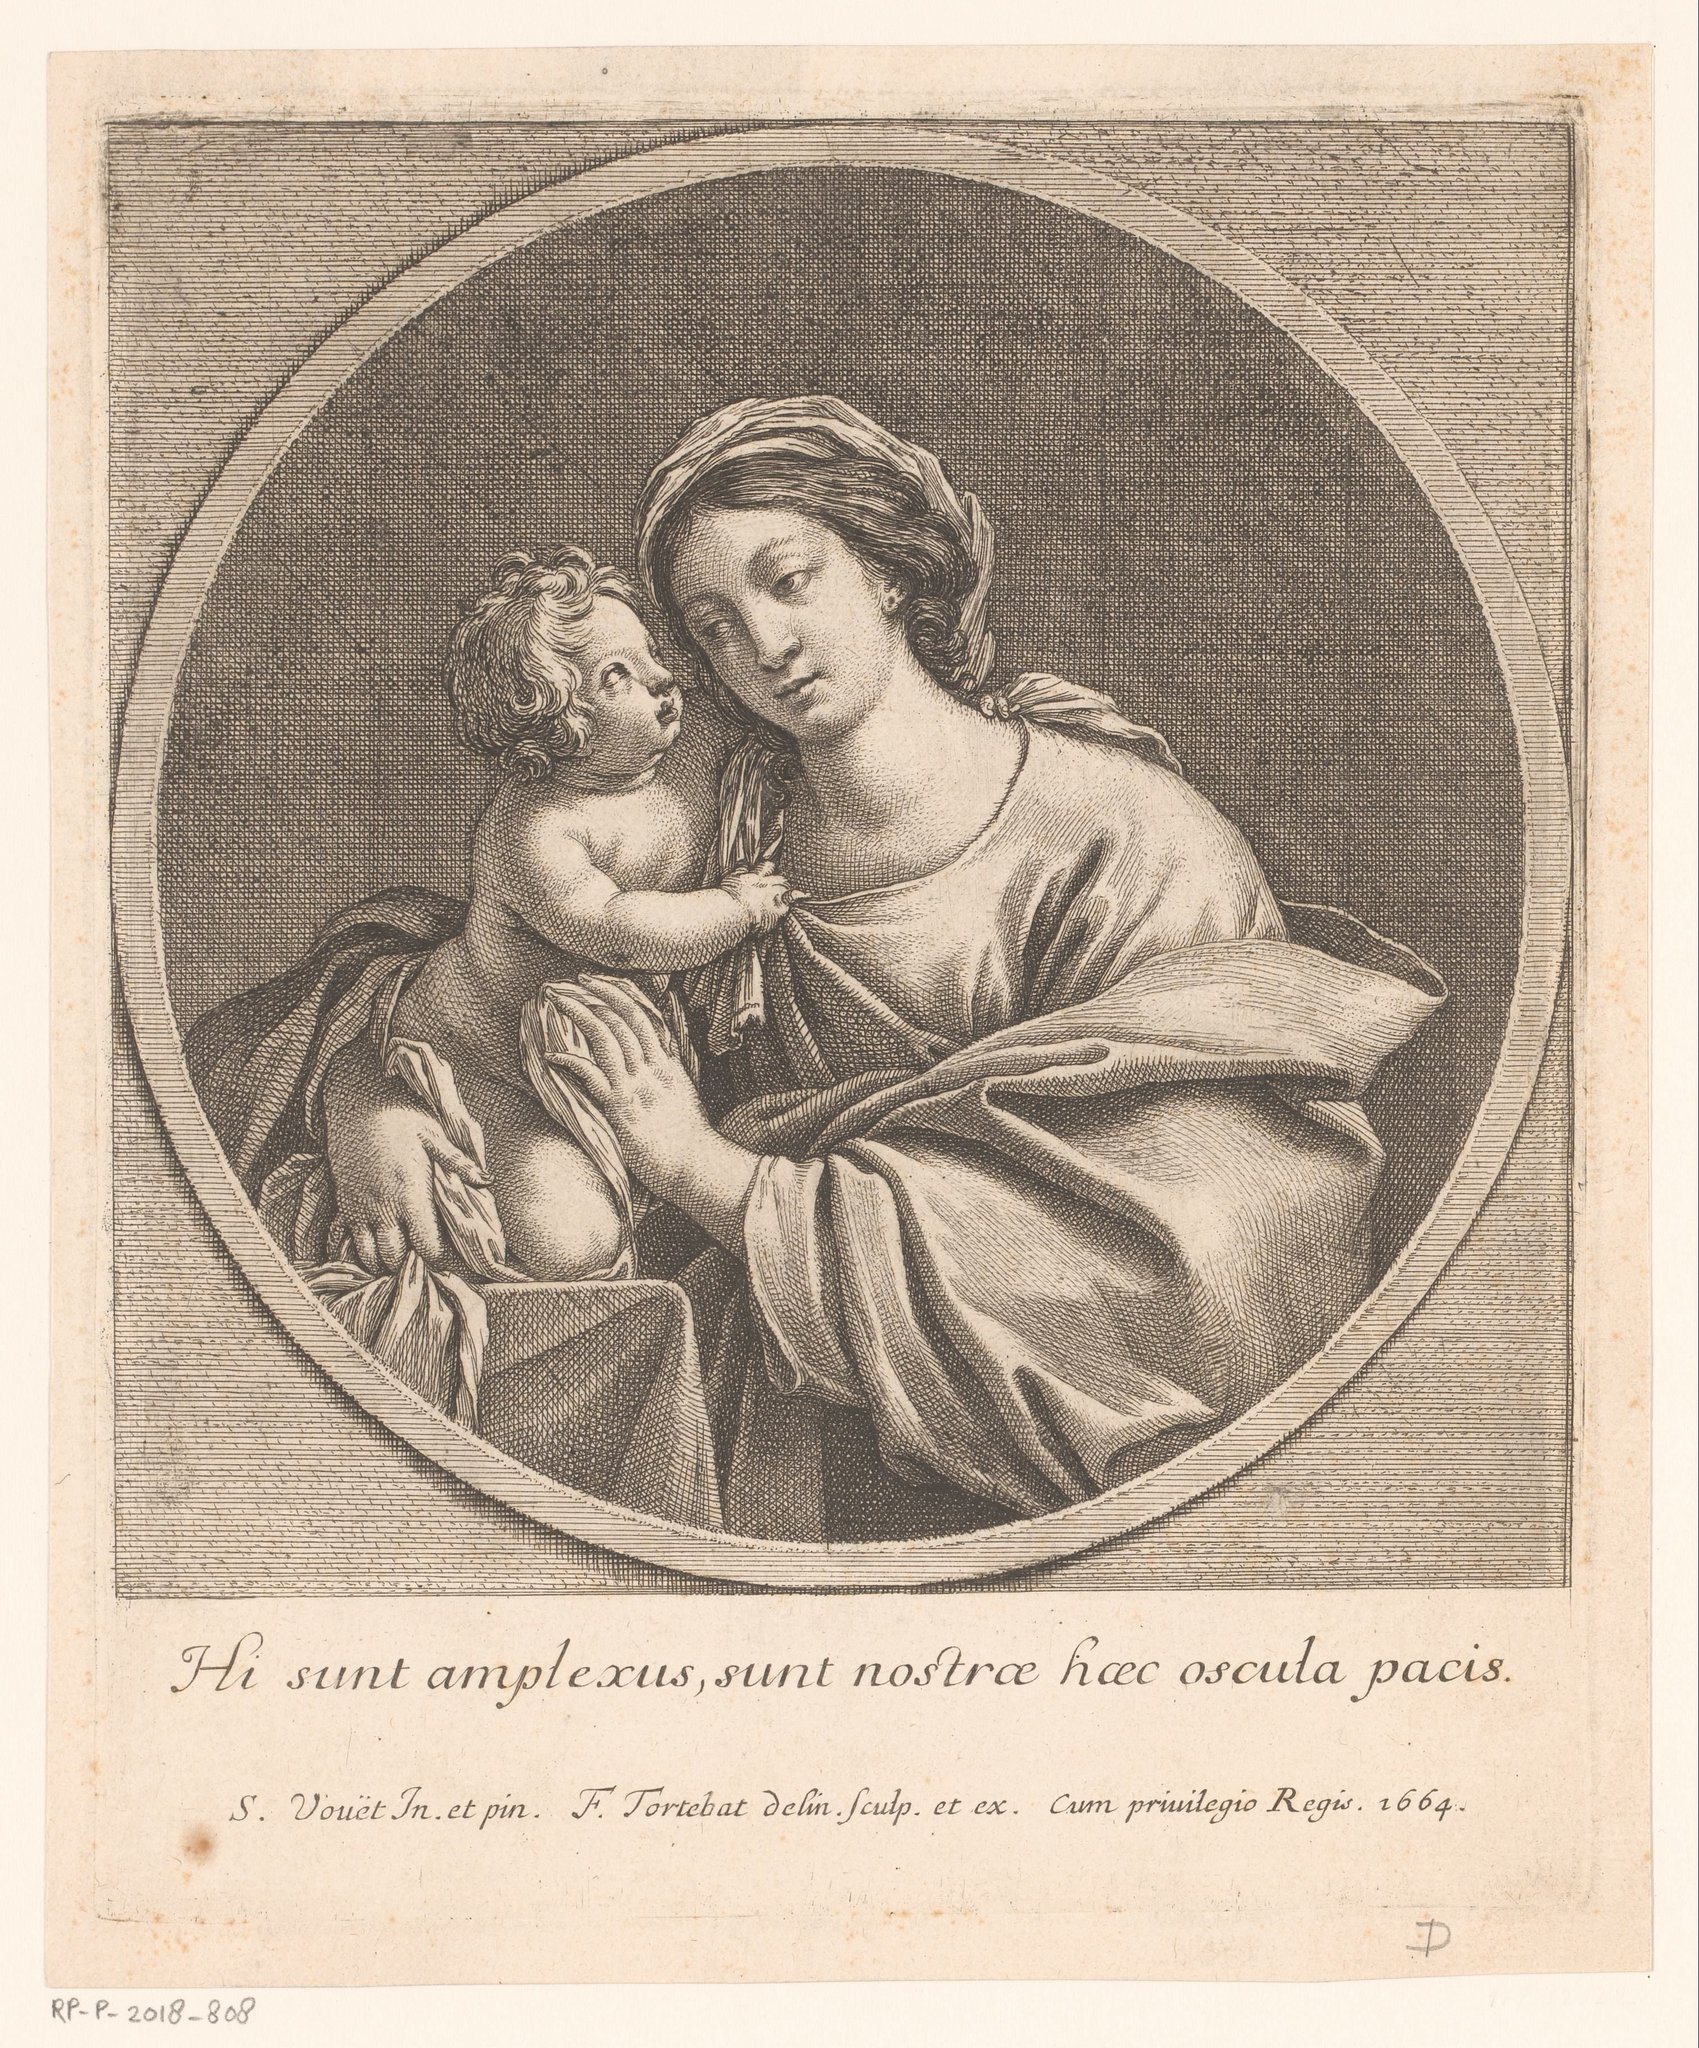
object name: print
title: Maria met Kind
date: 1664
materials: paper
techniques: engraving, etching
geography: paris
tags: madonna: mary (standing) with the christ-child free-standing (or leaning against her)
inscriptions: collector's mark: Lugt 2228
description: Maria met Kind in haar armen in een ronde omlijsting. Eenregelige Latijnse tekst in ondermarge.